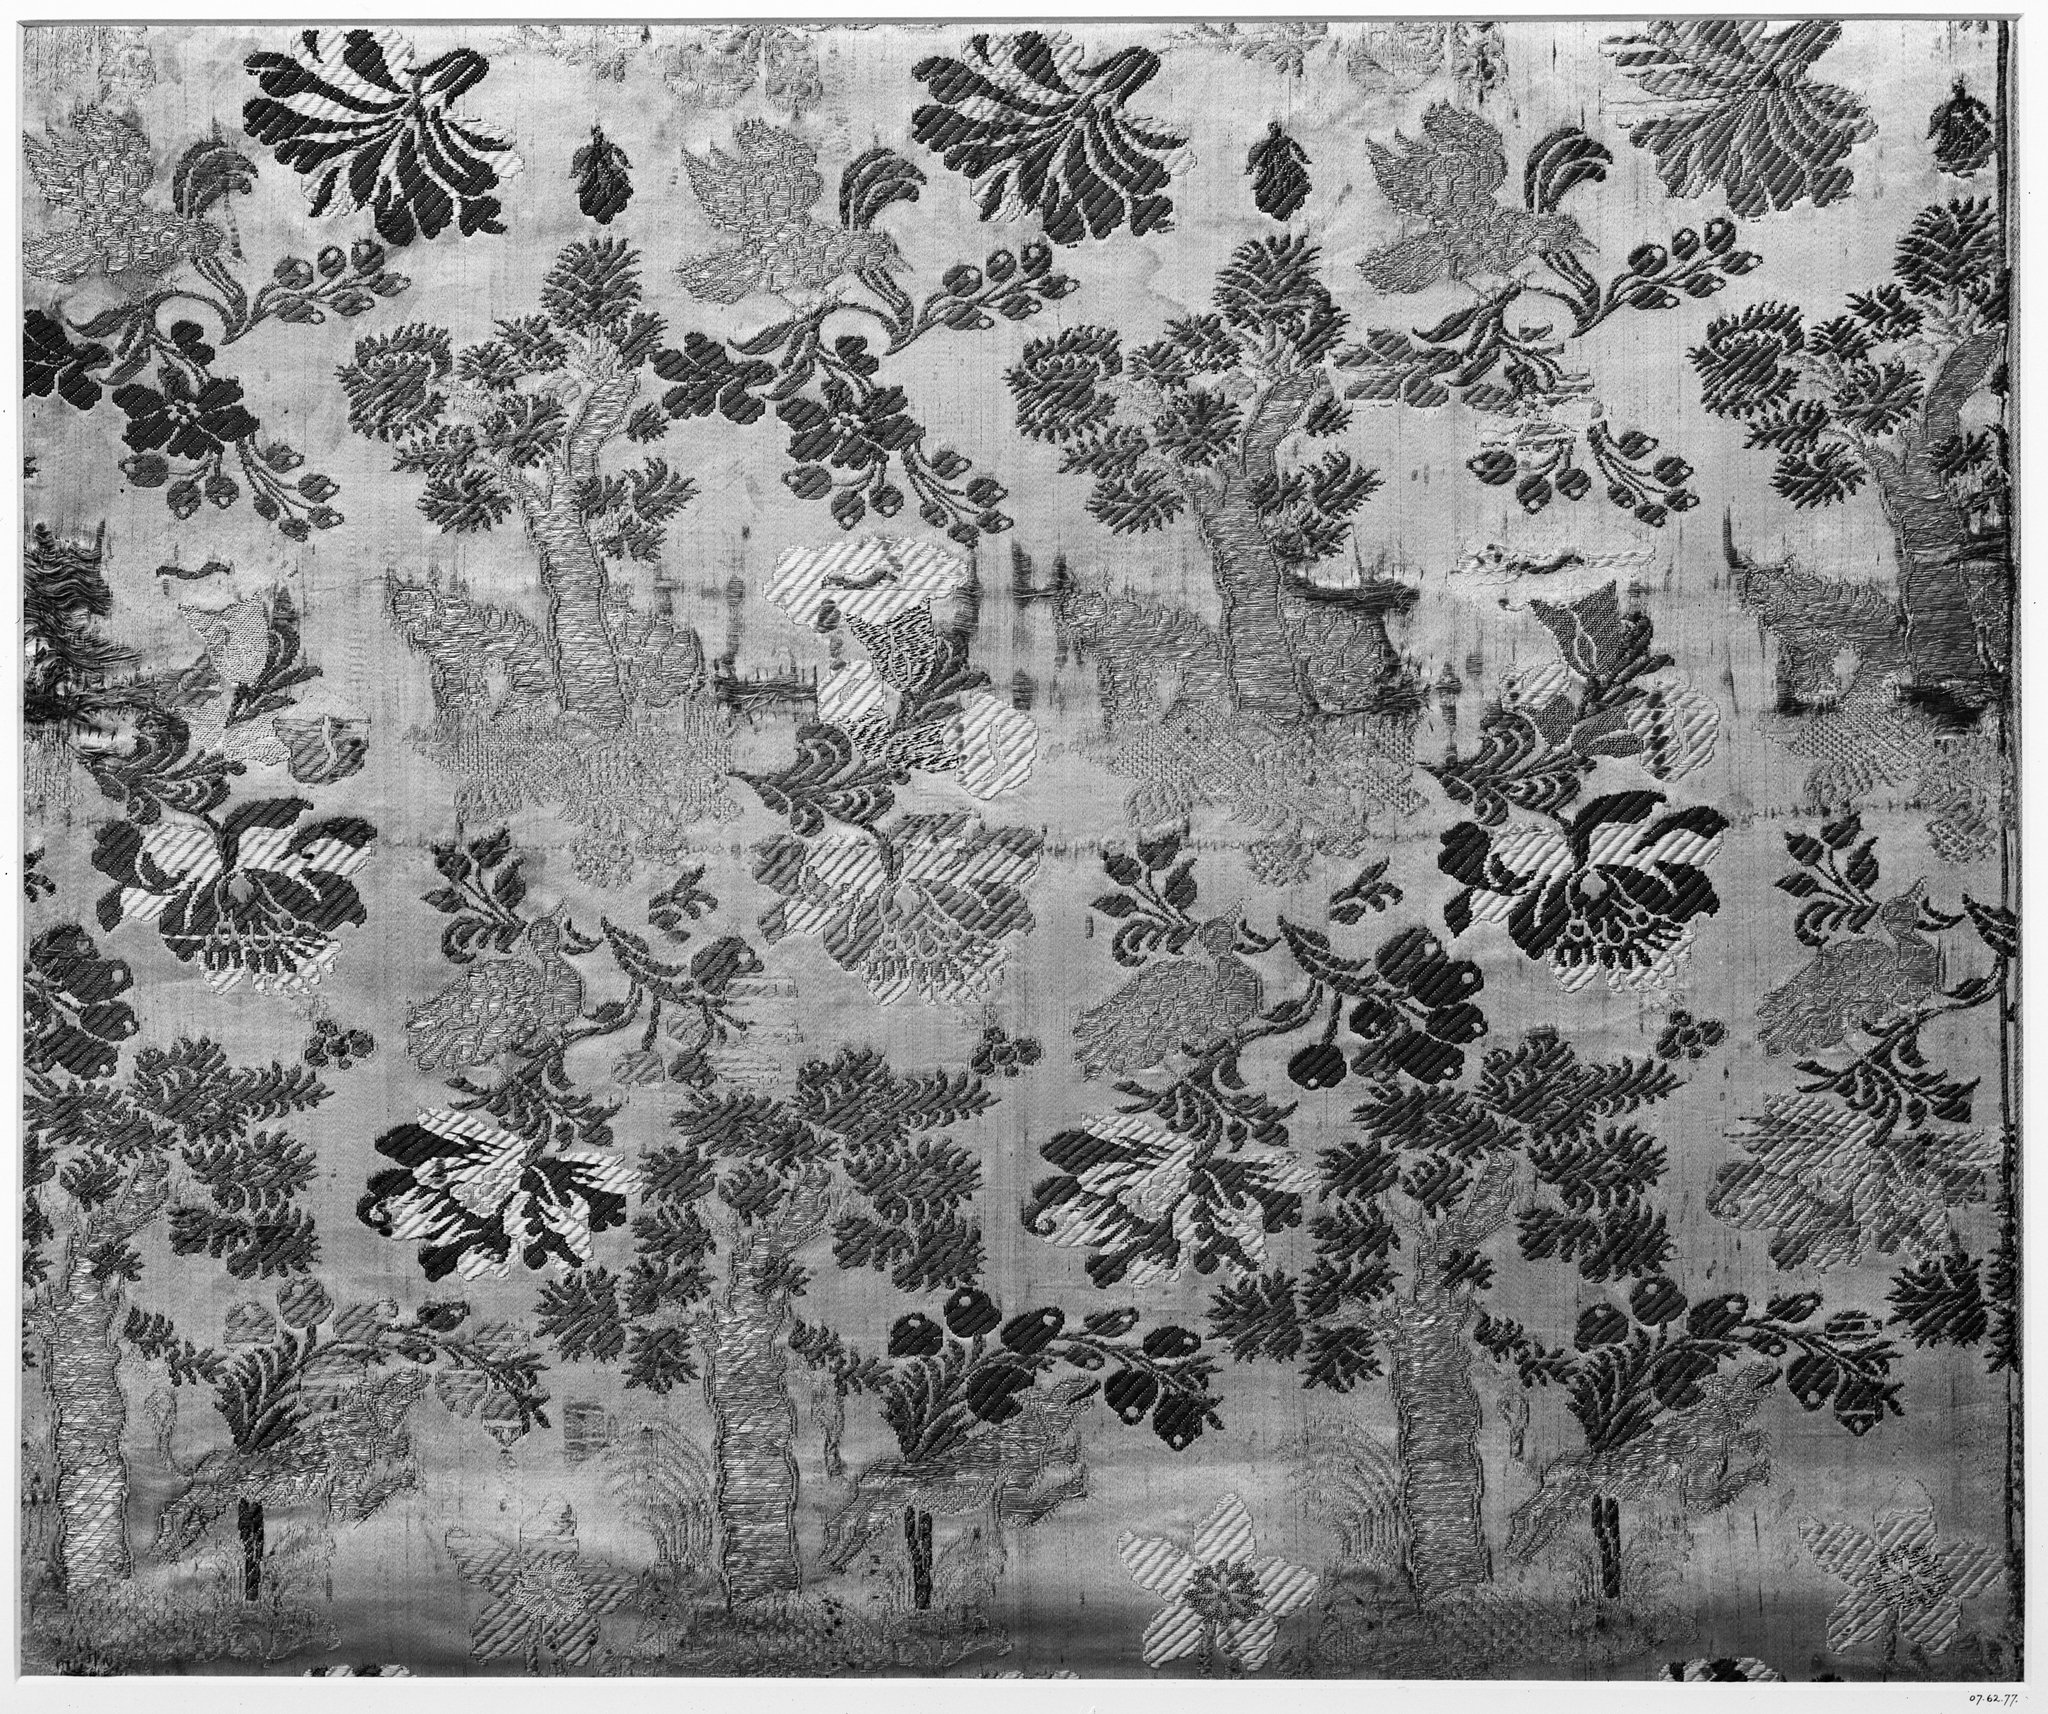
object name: piece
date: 1735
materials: metal thread, silk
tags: flowers,leaves,trees